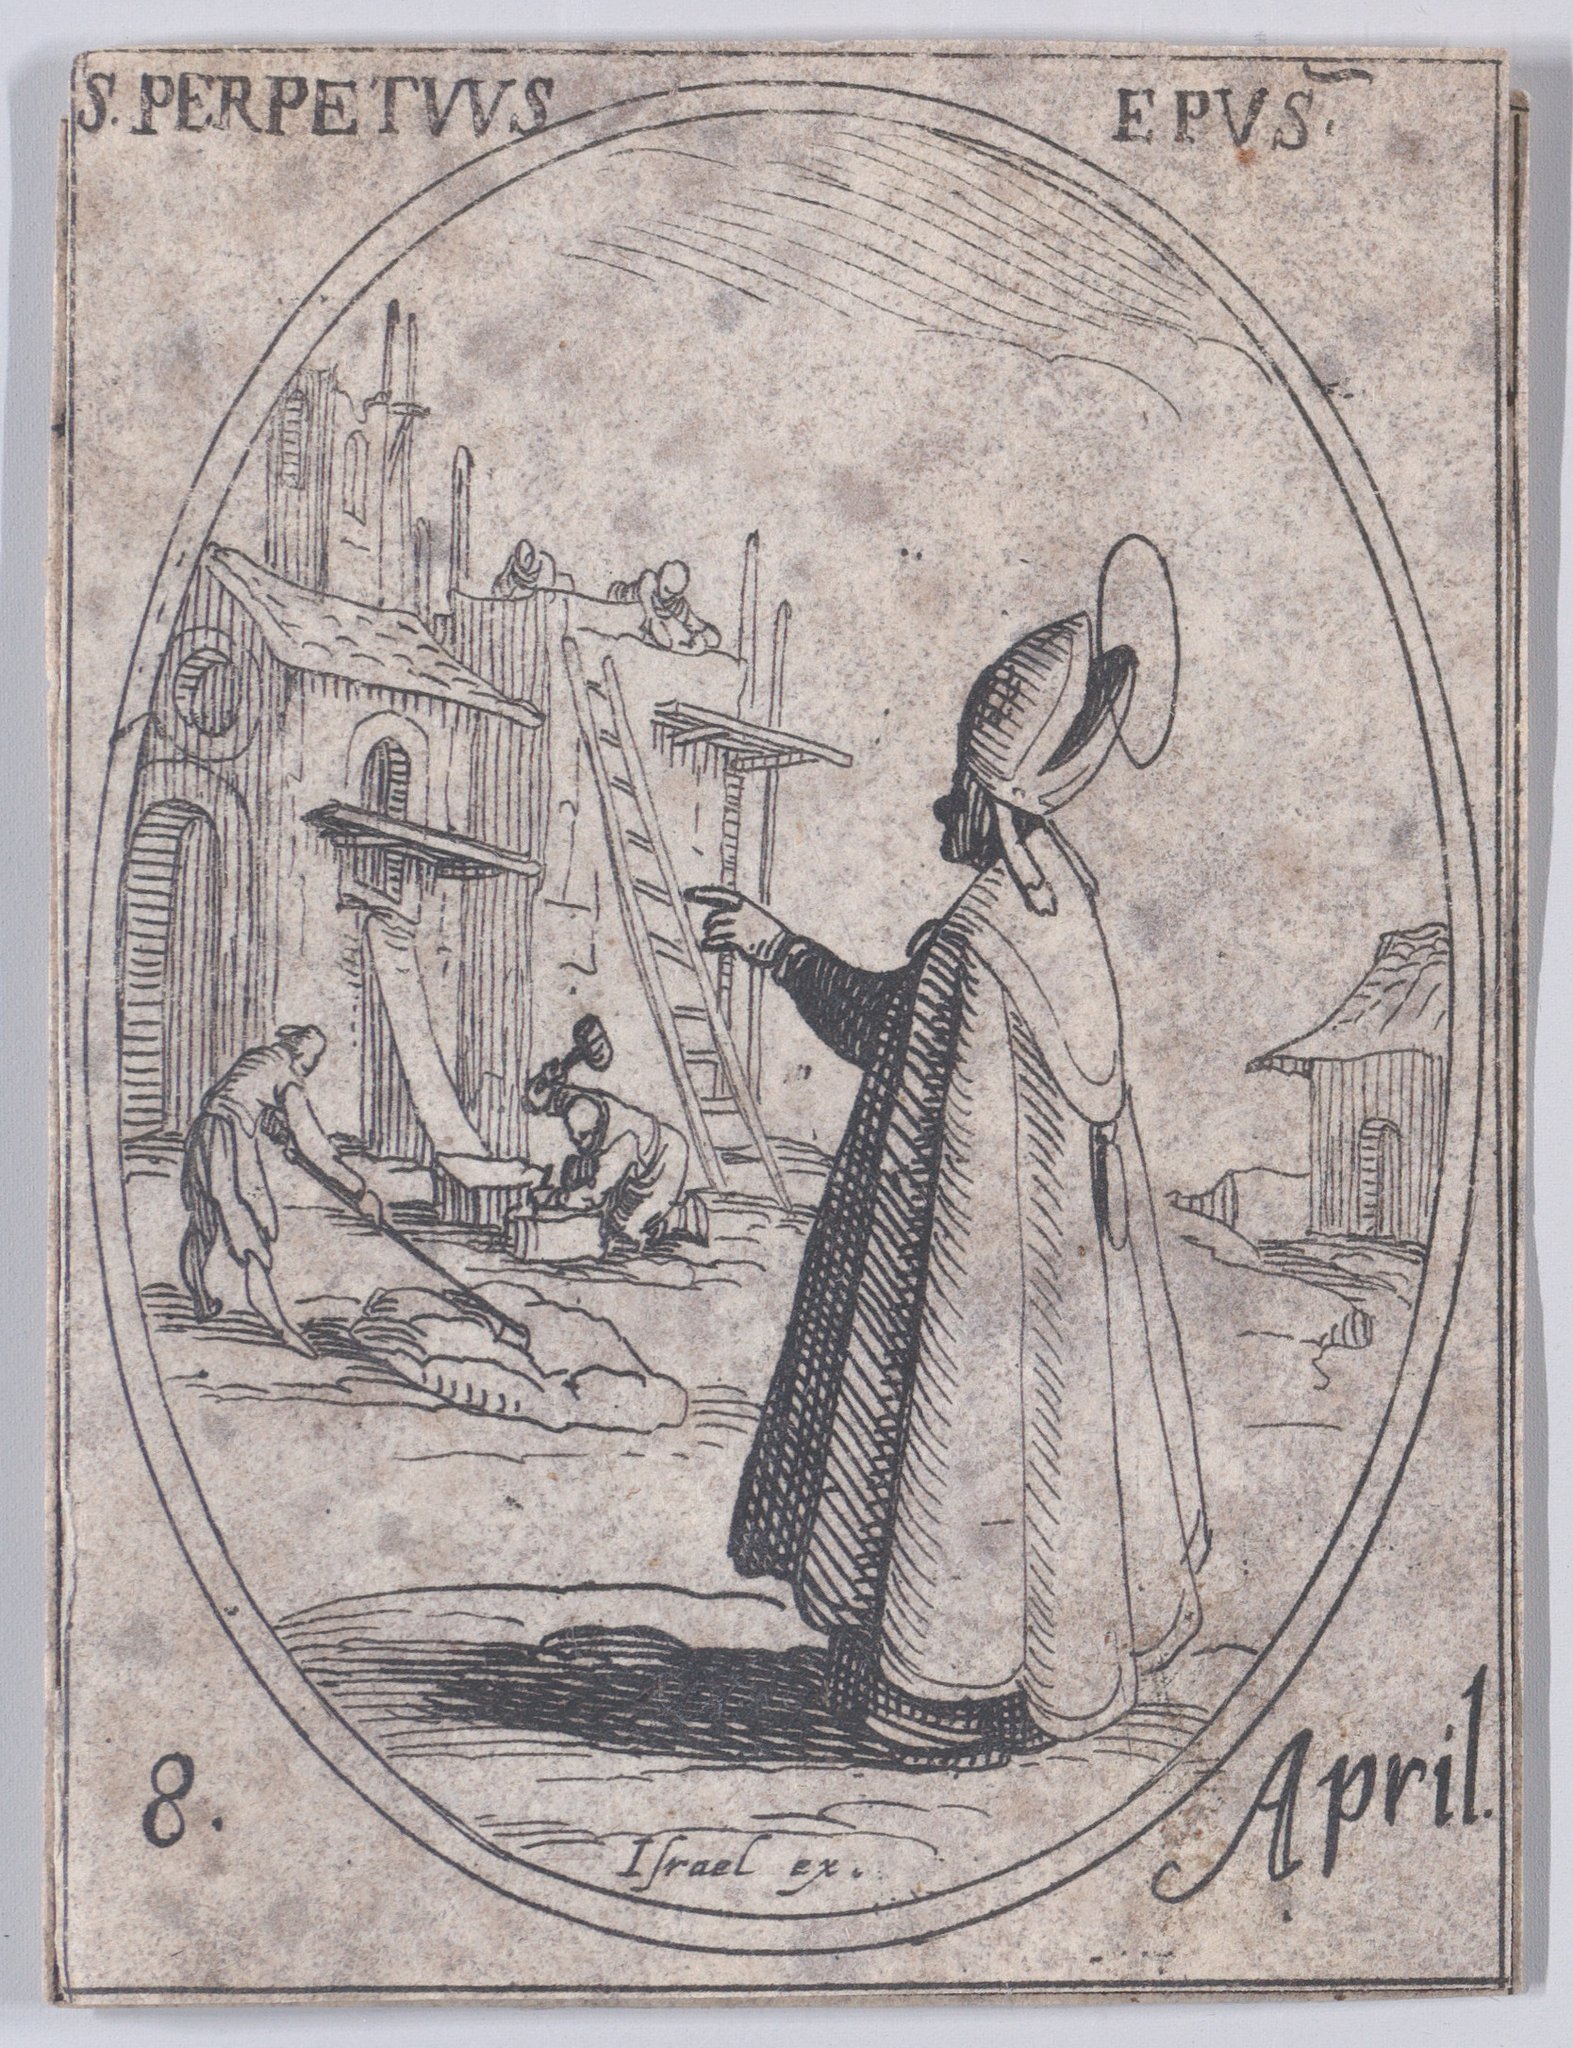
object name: print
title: S. Perpétue, évêque (St. Perpetuus, Bishop), April 8th, from "Les Images De Tous Les Saincts et Saintes de L'Année" (Images of All of the Saints and Religious Events of the Year)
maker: jacques callot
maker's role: artist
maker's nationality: french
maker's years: 1592-1635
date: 1636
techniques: etching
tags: men,saints